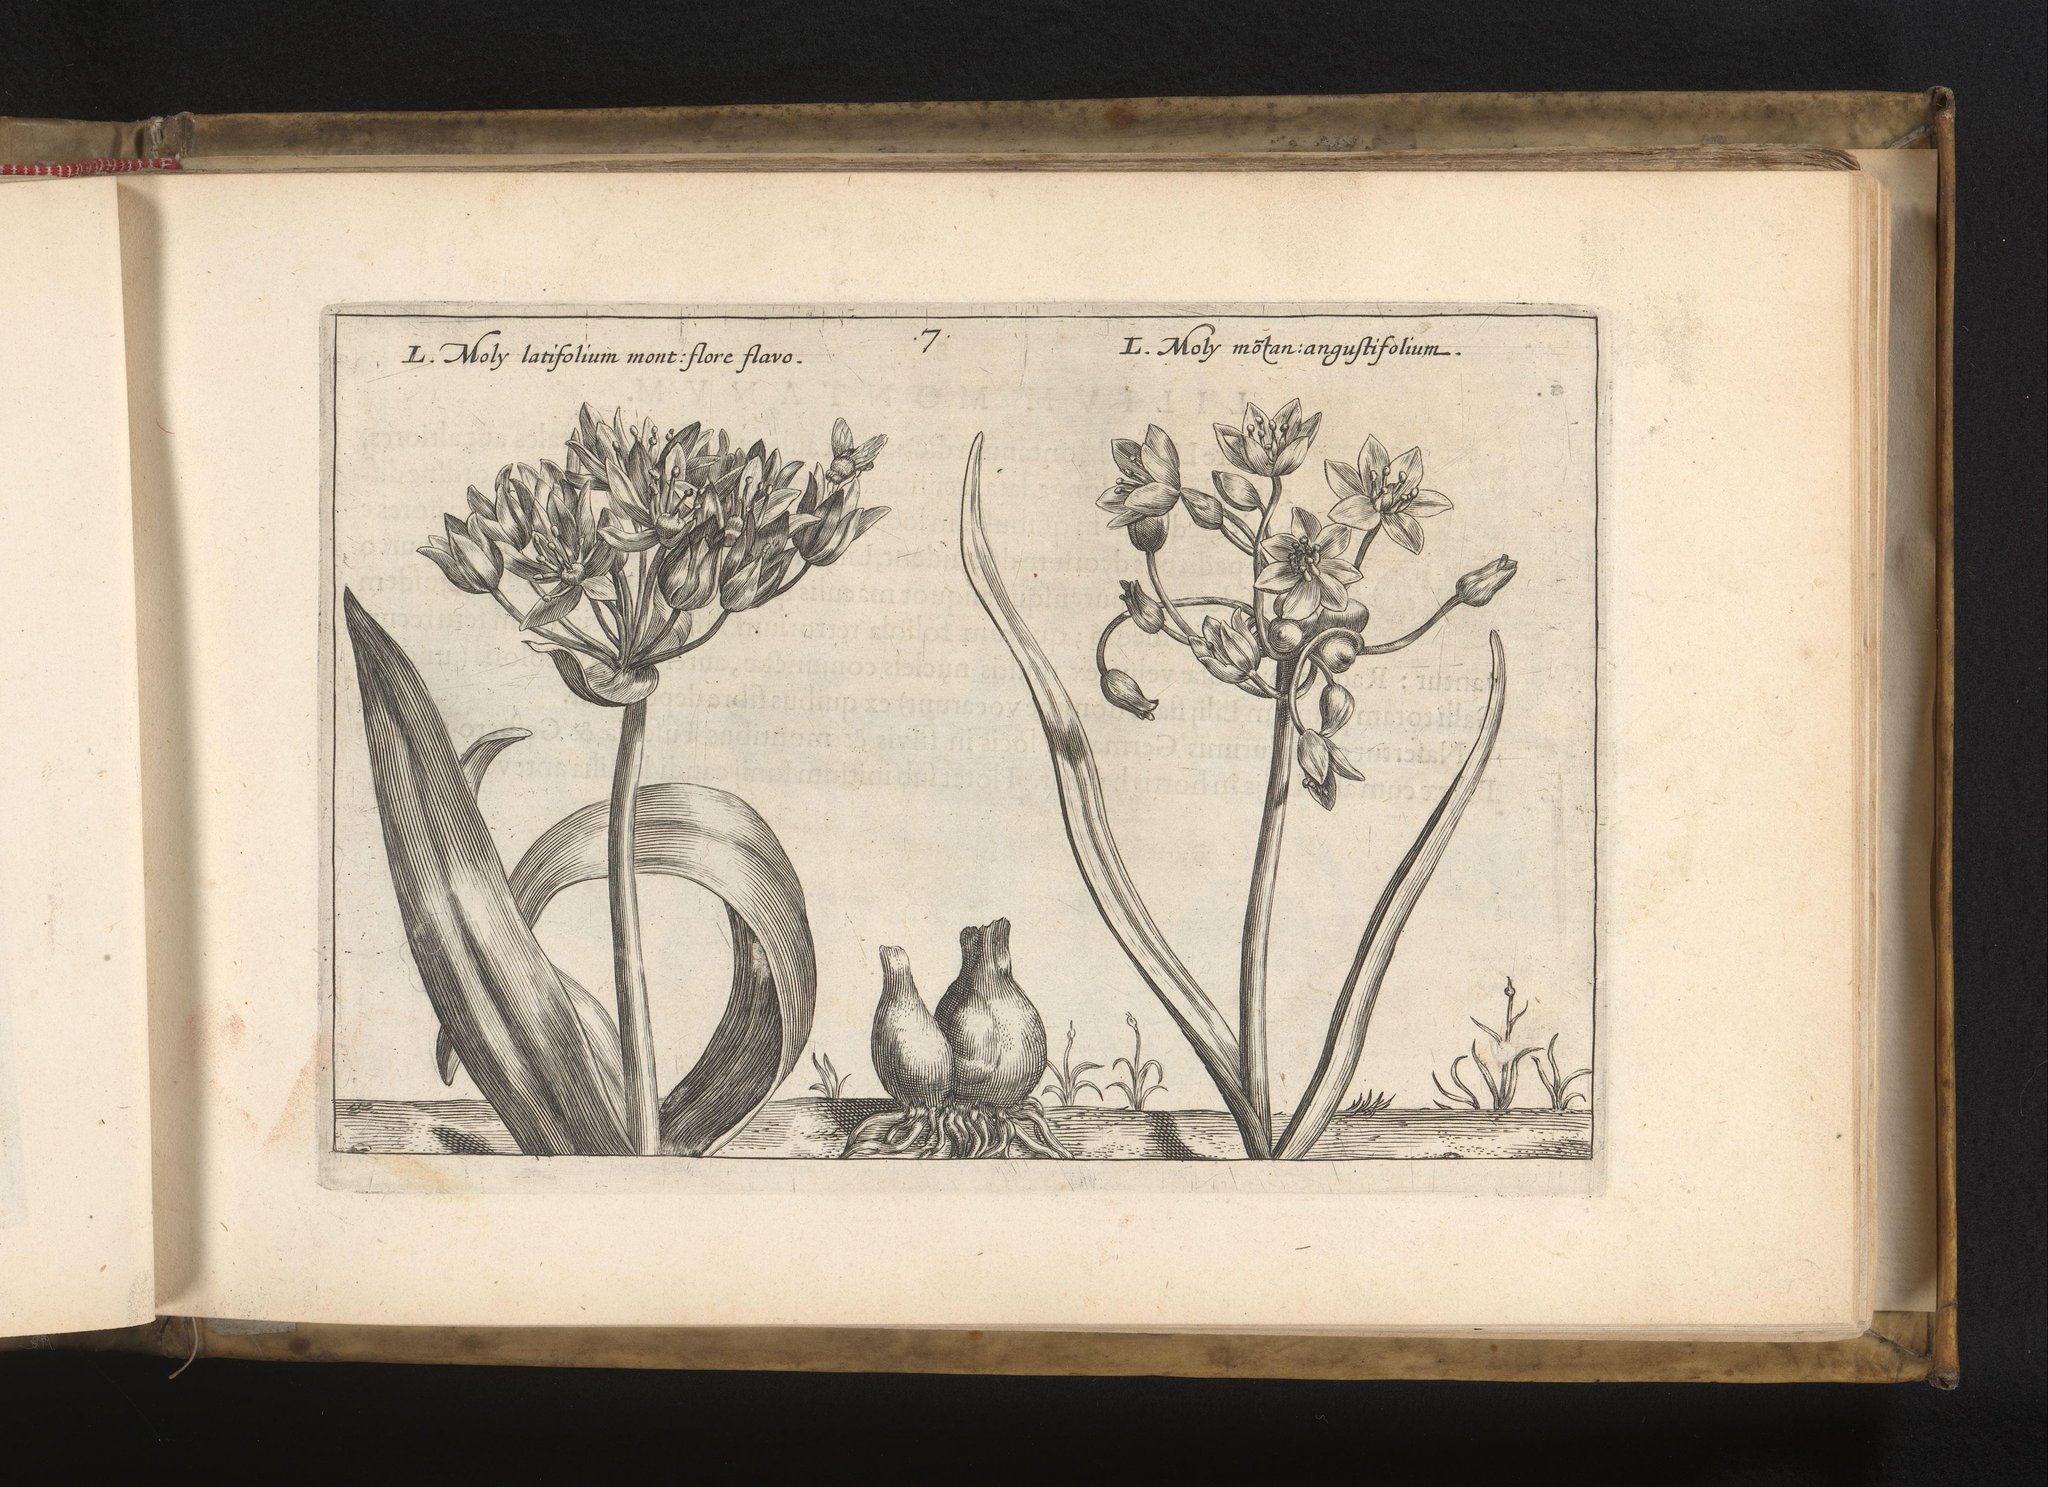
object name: book illustration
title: Bloementuin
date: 1617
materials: paper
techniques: engraving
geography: arnhem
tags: flowers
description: Prent uit: Passe, Crispijn van de (II). Hortus floridus in quo rariorum & minus vulgarium florum icones ad vivam veramque formam. Arnhem: Johannes Janssonius, 1617.